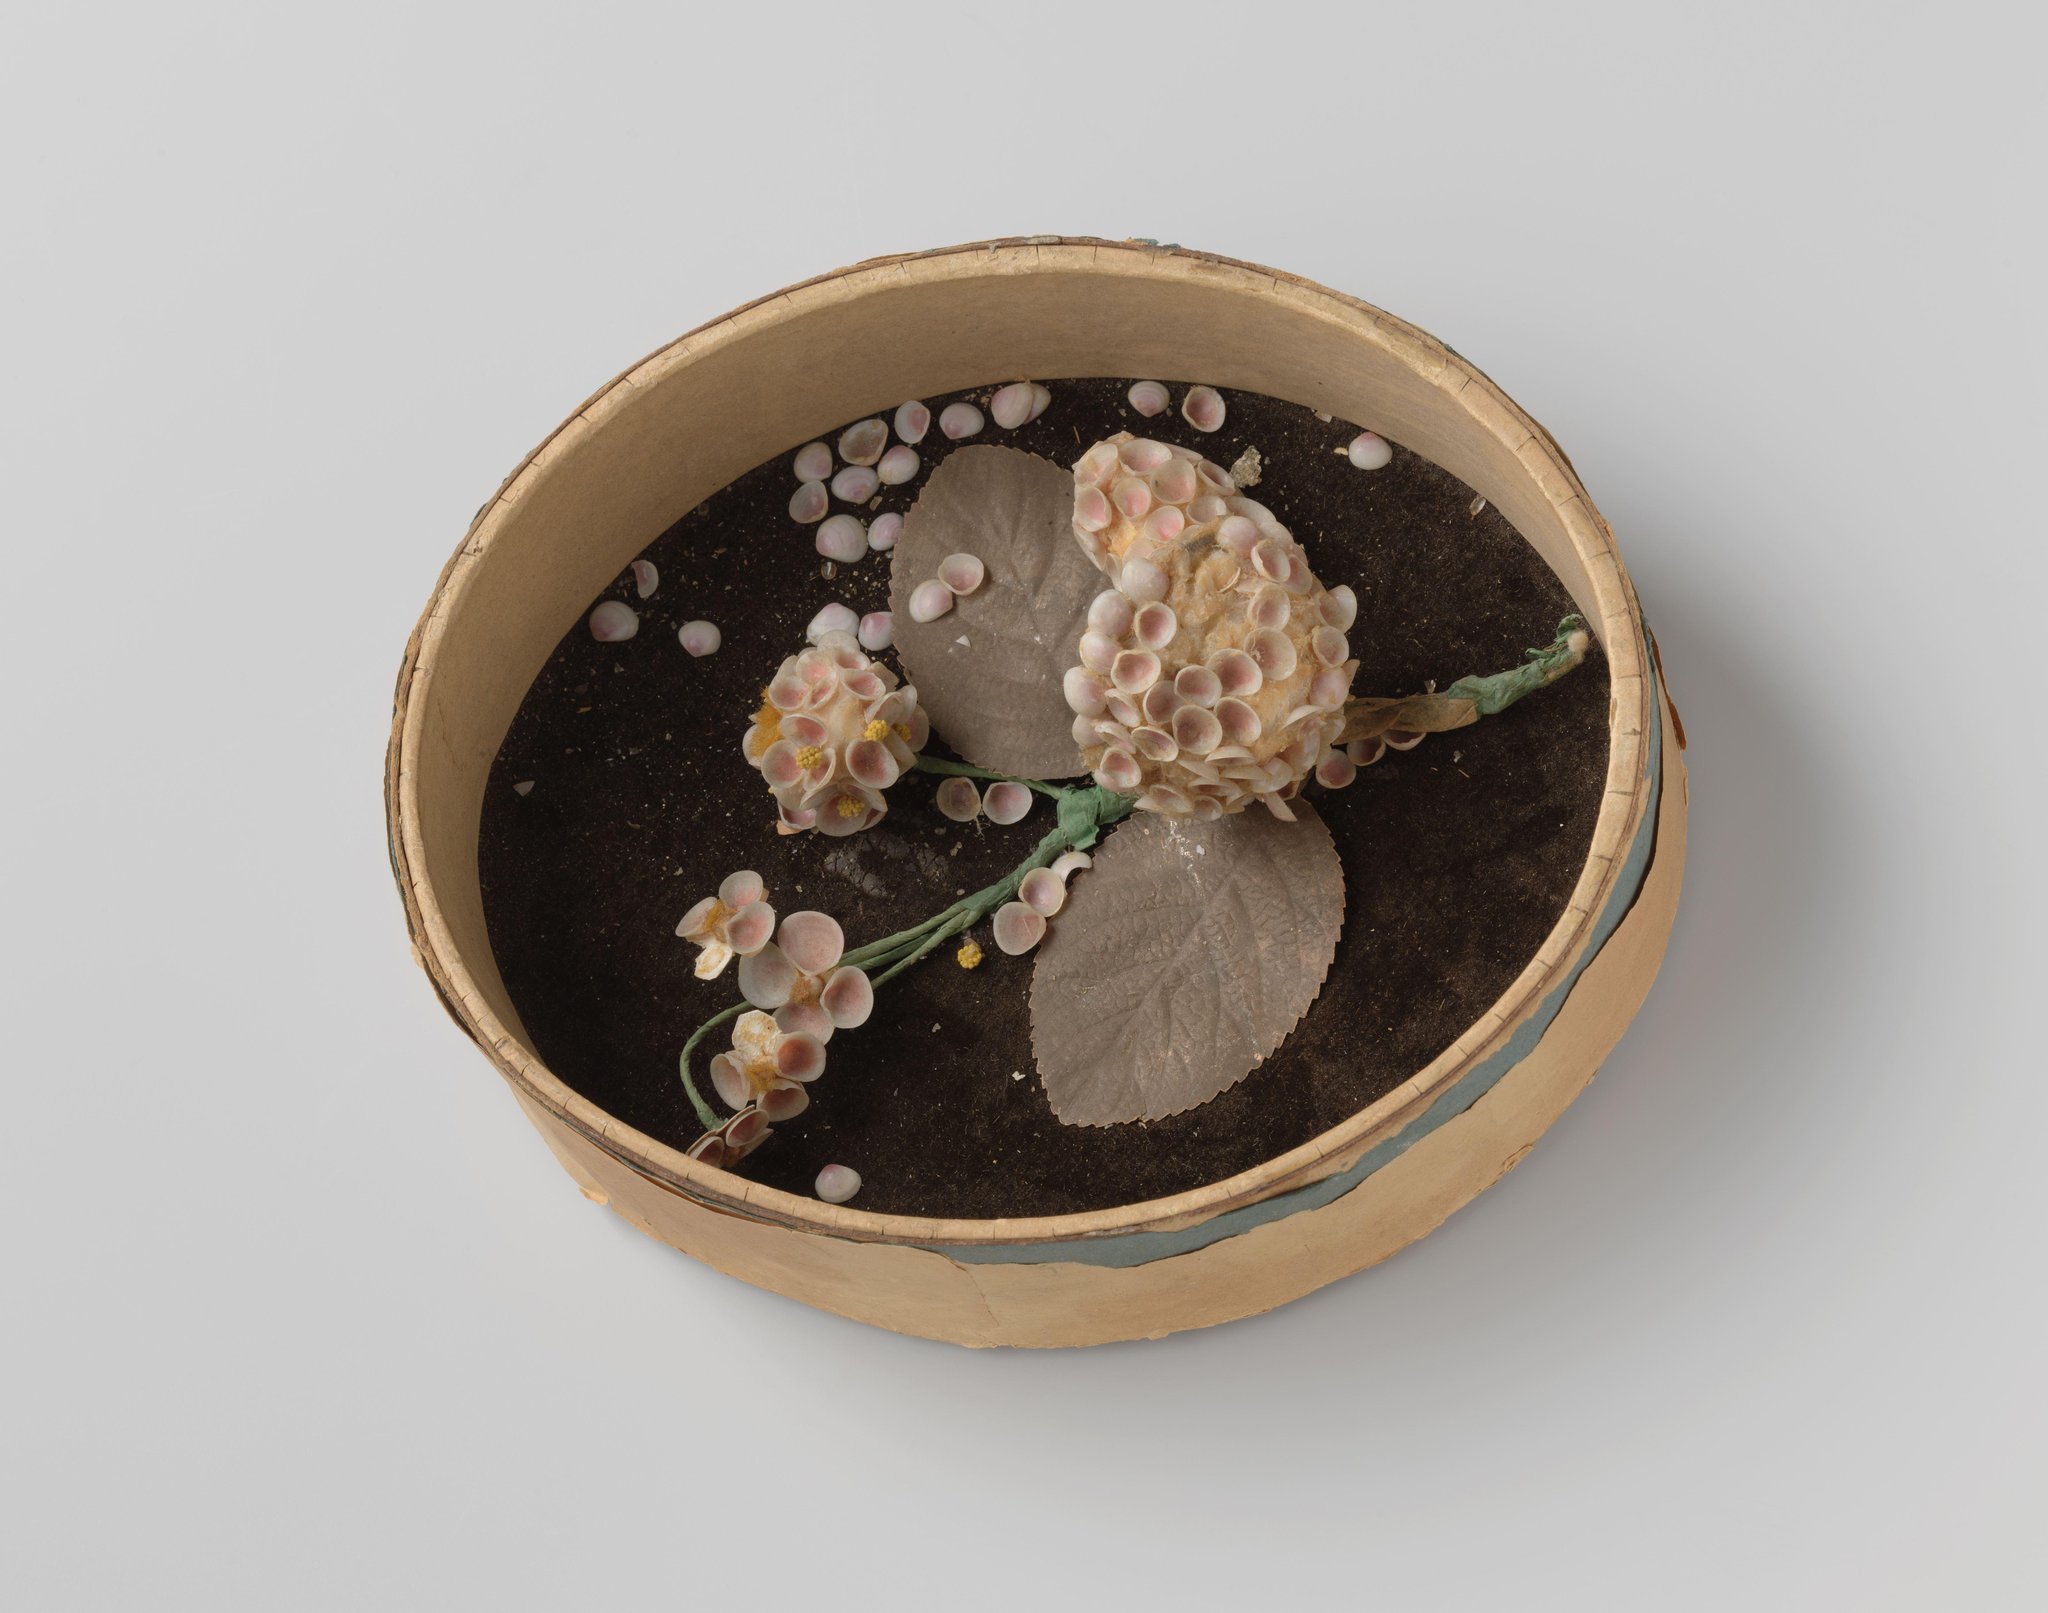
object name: decoratief object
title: Boeket bestaande uit schelpen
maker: Anonymous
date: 1885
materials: cardboard, shell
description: Op de achterkant van de doos: Schelpjes uit de West medegenomen door uwen Vader in 1885. Bijéén verzameld door uwe Grootmoeder. December 1885.